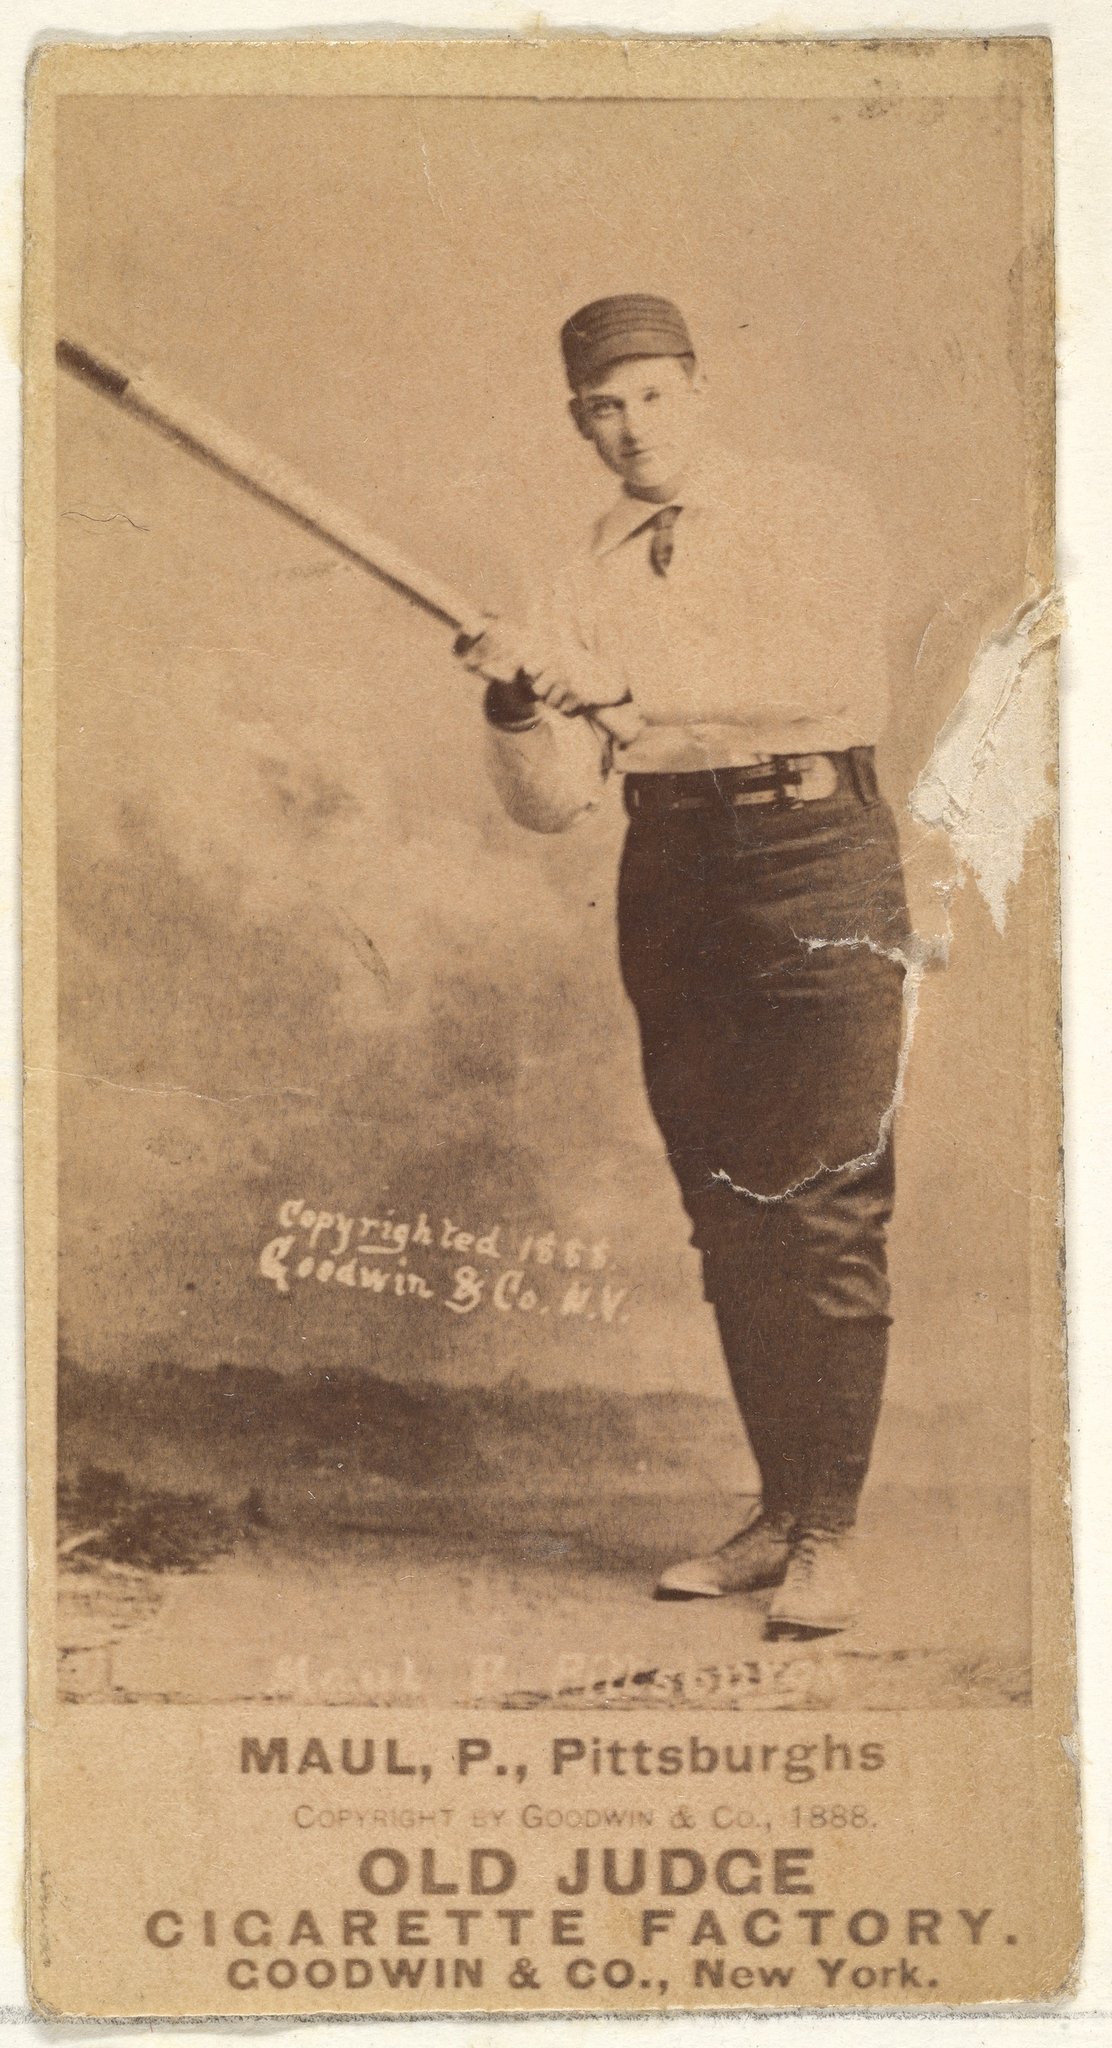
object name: baseball card, photograph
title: Al Maul, Pitcher, Pittsburgh, from the Old Judge series (N172) for Old Judge Cigarettes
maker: goodwin & company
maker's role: publisher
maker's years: 1850-1950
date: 1888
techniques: albumen silver print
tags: men,portraits,baseball,athletes